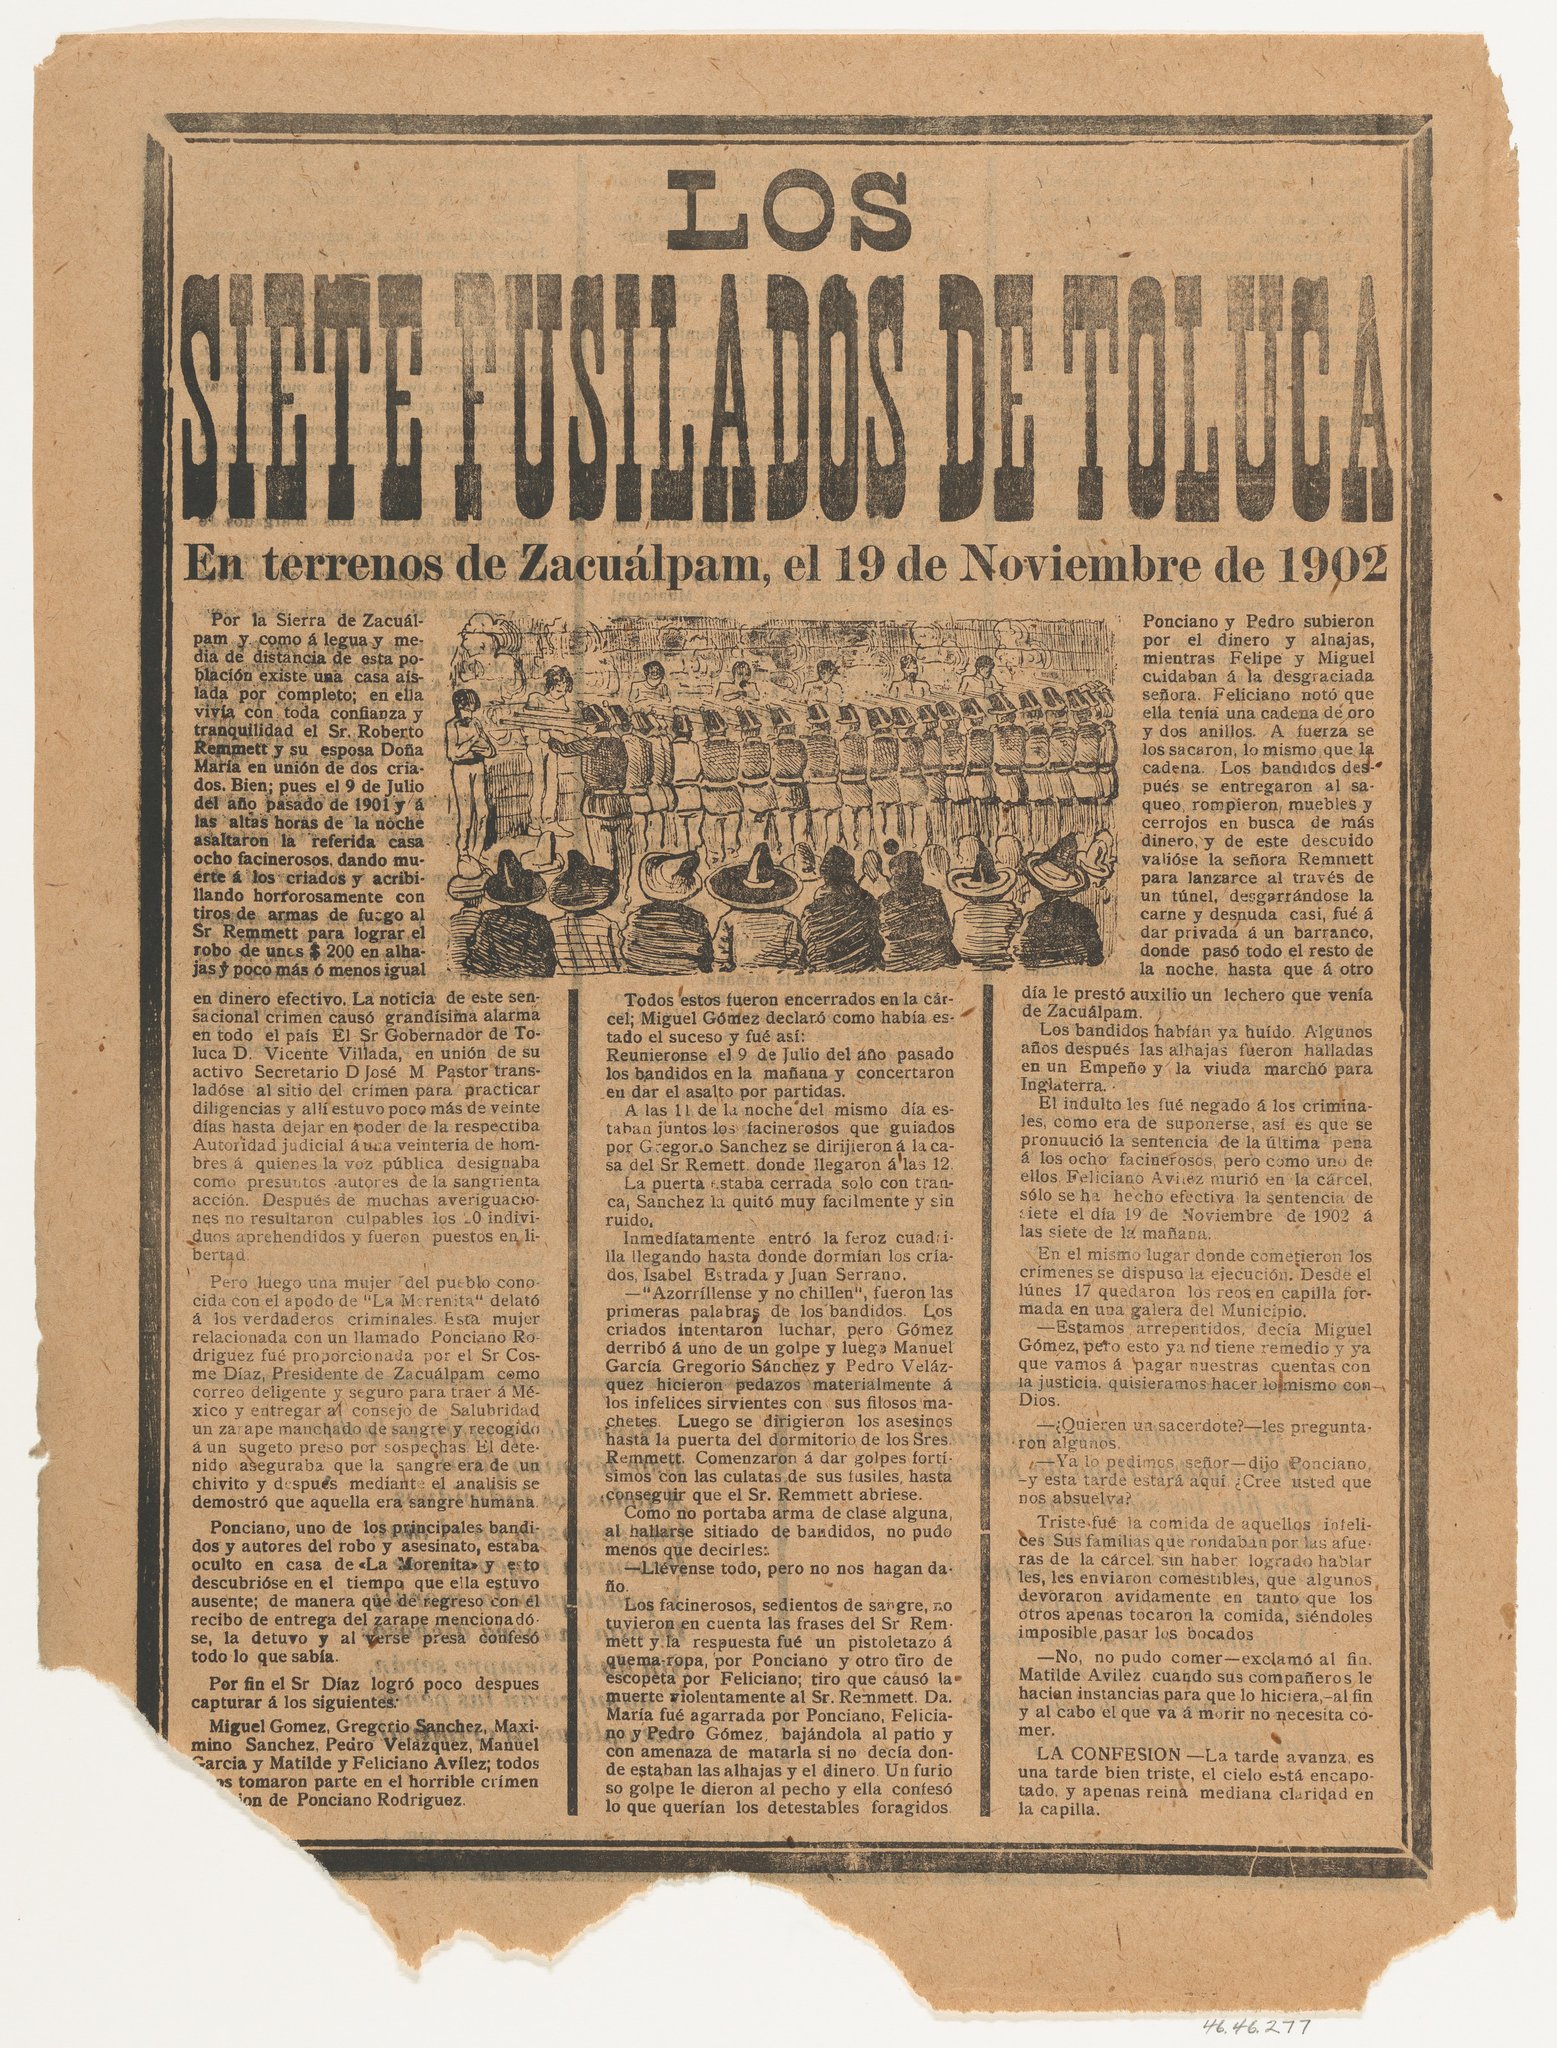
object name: print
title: Broadsheet relating to seven men being executed by a firing squad on 19 November 1902 on account of their murder on July 9 of the entire household of Sr Remmett in Toluca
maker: josé guadalupe posada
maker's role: artist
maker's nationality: mexican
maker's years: 1852-1913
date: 1902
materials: paper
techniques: letterpress, lithography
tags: execution